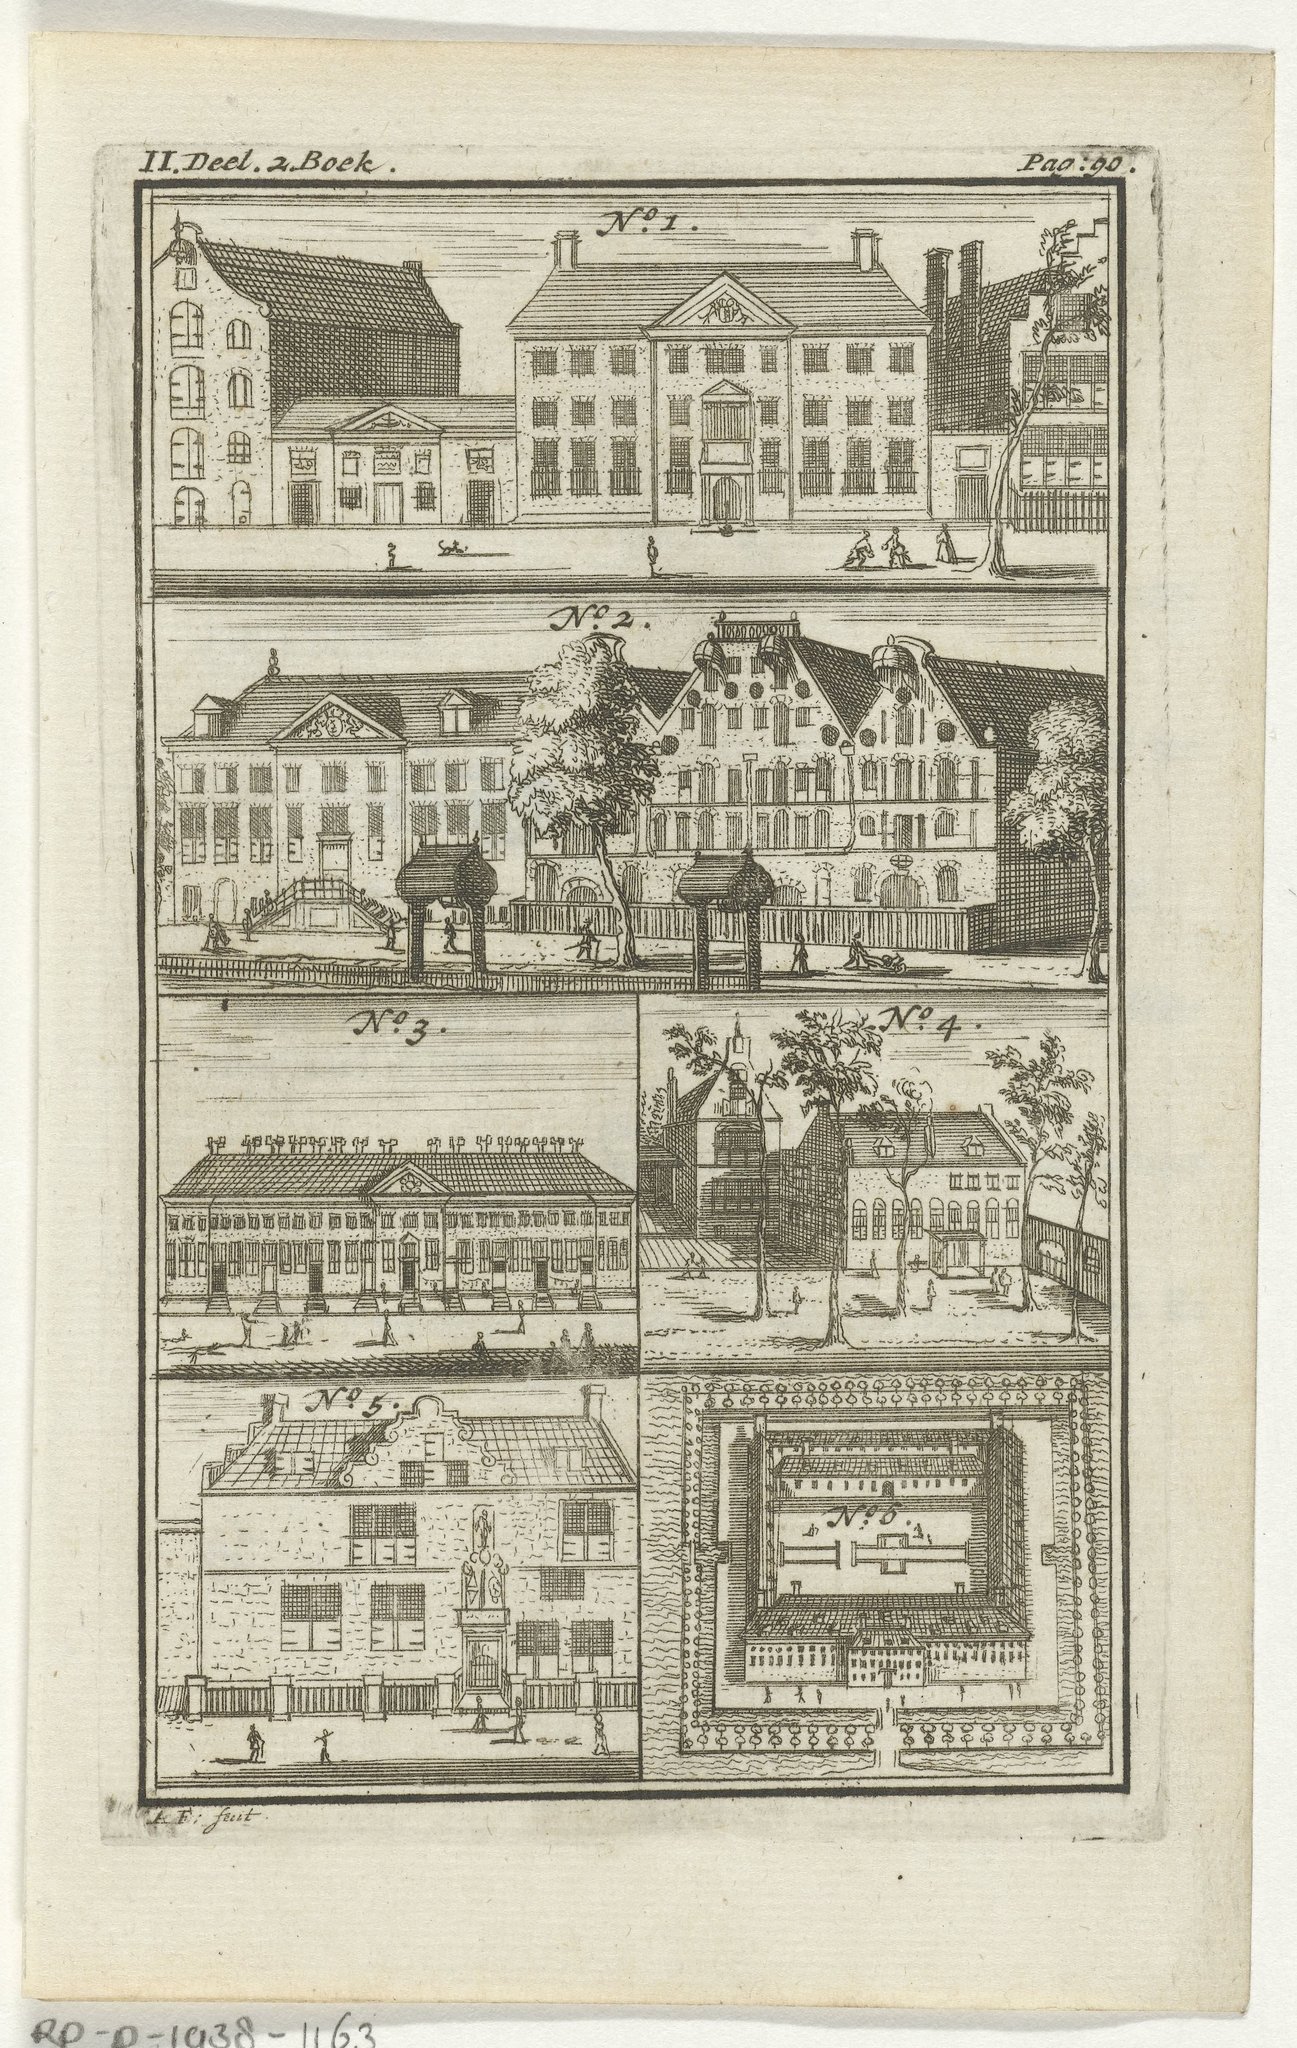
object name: book illustration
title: Zes verschillende gebouwen te Amsterdam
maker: anna folkema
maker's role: draughtsman, print maker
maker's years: 1695-1768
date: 1723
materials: paper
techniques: etching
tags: civic architecture; edifices; dwellings, dolhuis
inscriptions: collector's mark: Lugt 2760, collector's mark: Lugt 2228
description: Zes genummerde gebouwen te Amsterdam: Nieuwezijds Huiszittenhuis, Oudezijds Huiszittenhuis, Karthuizer Weduwenhof, Leprozenhuis, Dolhuis, Buitengasthuis. De gebouwen zijn op het bijbehorende tekstblad voorzien van toelichting. Prent links- en rechtsboven gemerkt: II. Deel. 2. Boek - Pag: 90.